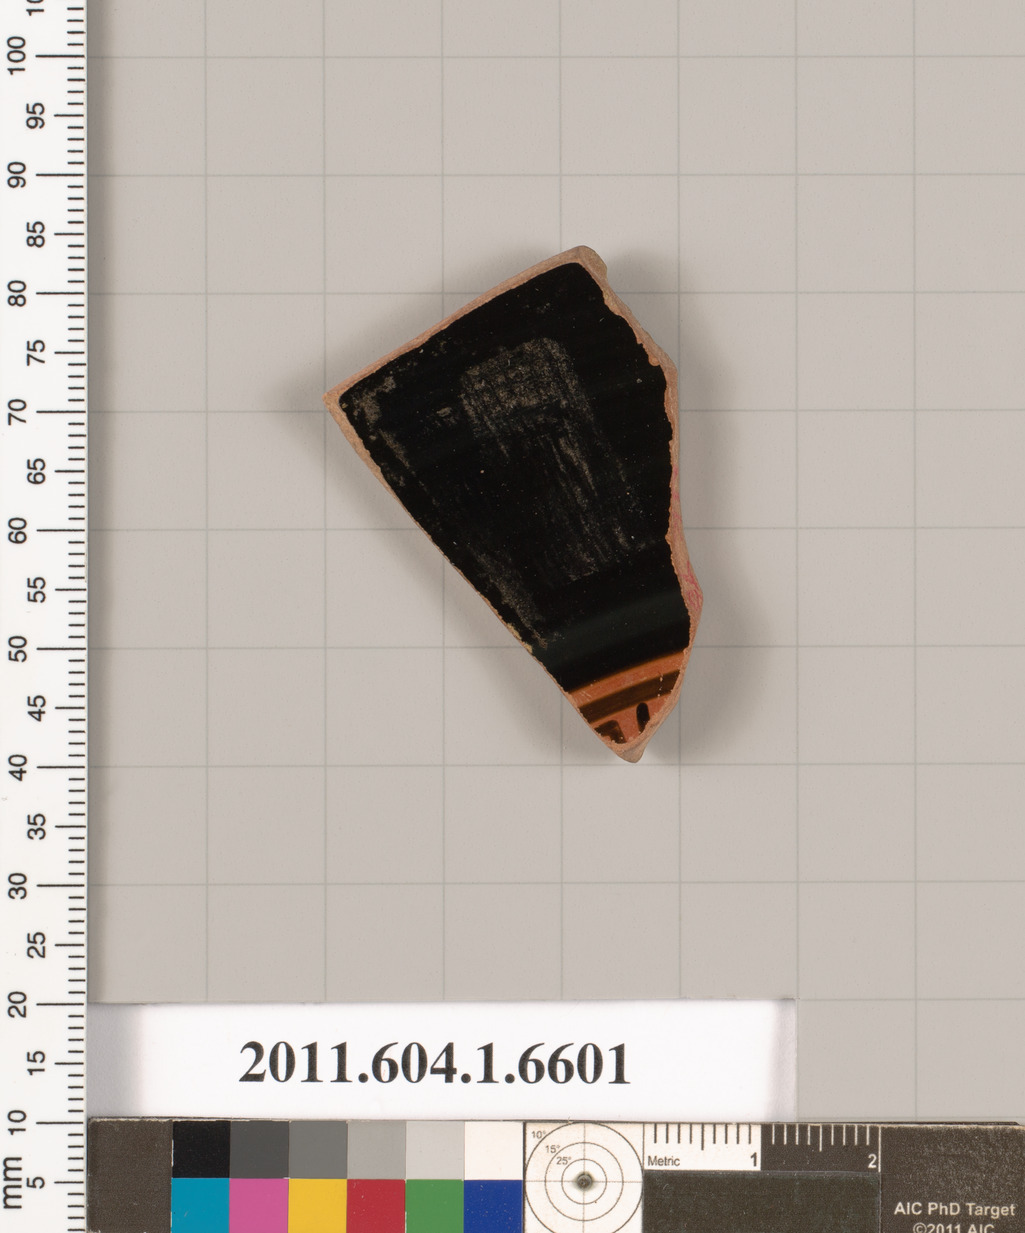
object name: kylix fragment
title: Terracotta fragment of a kylix (drinking cup)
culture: greek, attic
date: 490-480 BCE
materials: terracotta